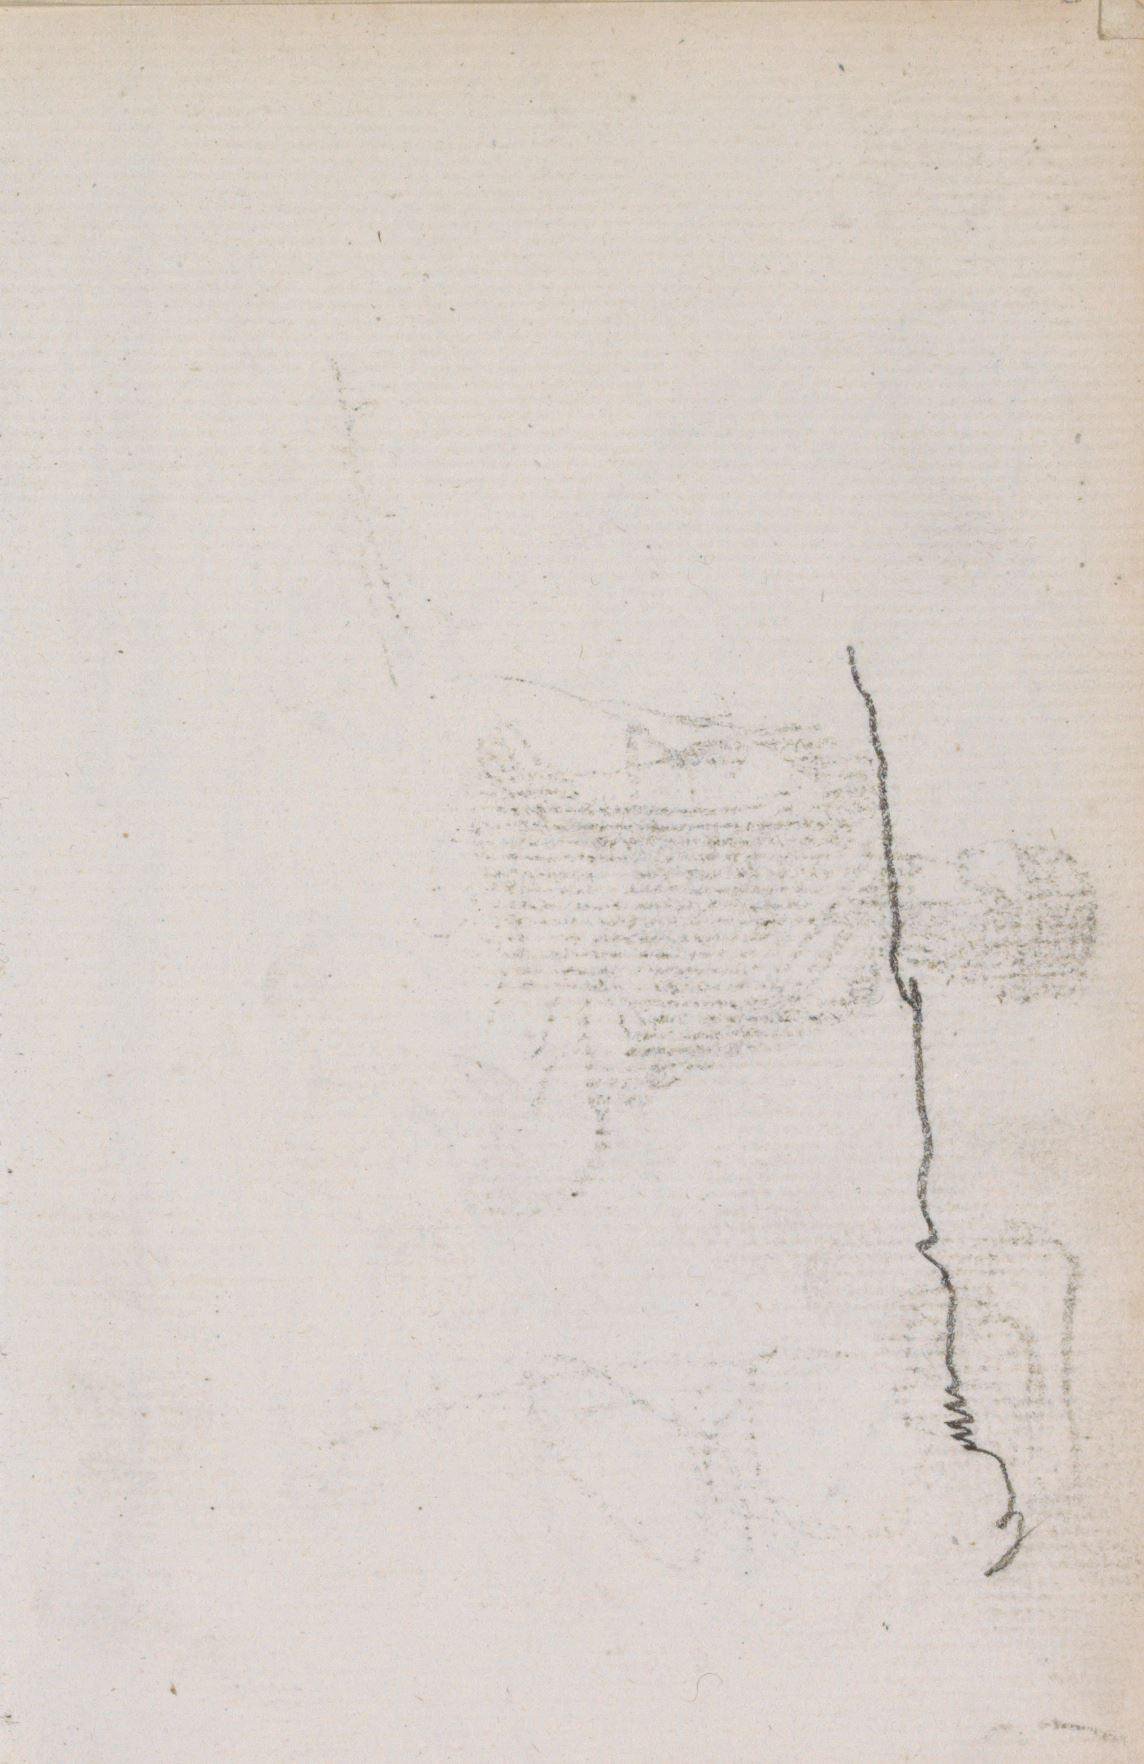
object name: sketchbook leaf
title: Studie, mogelijk van een landschap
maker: george hendrik breitner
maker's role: draughtsman, painter, print maker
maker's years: 1857-1923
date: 1884-1886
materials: chalk, paper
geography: drenthe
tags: landscapes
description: Pagina 20 uit een schetsboek met 67 bladen vervaardigd in Drenthe.